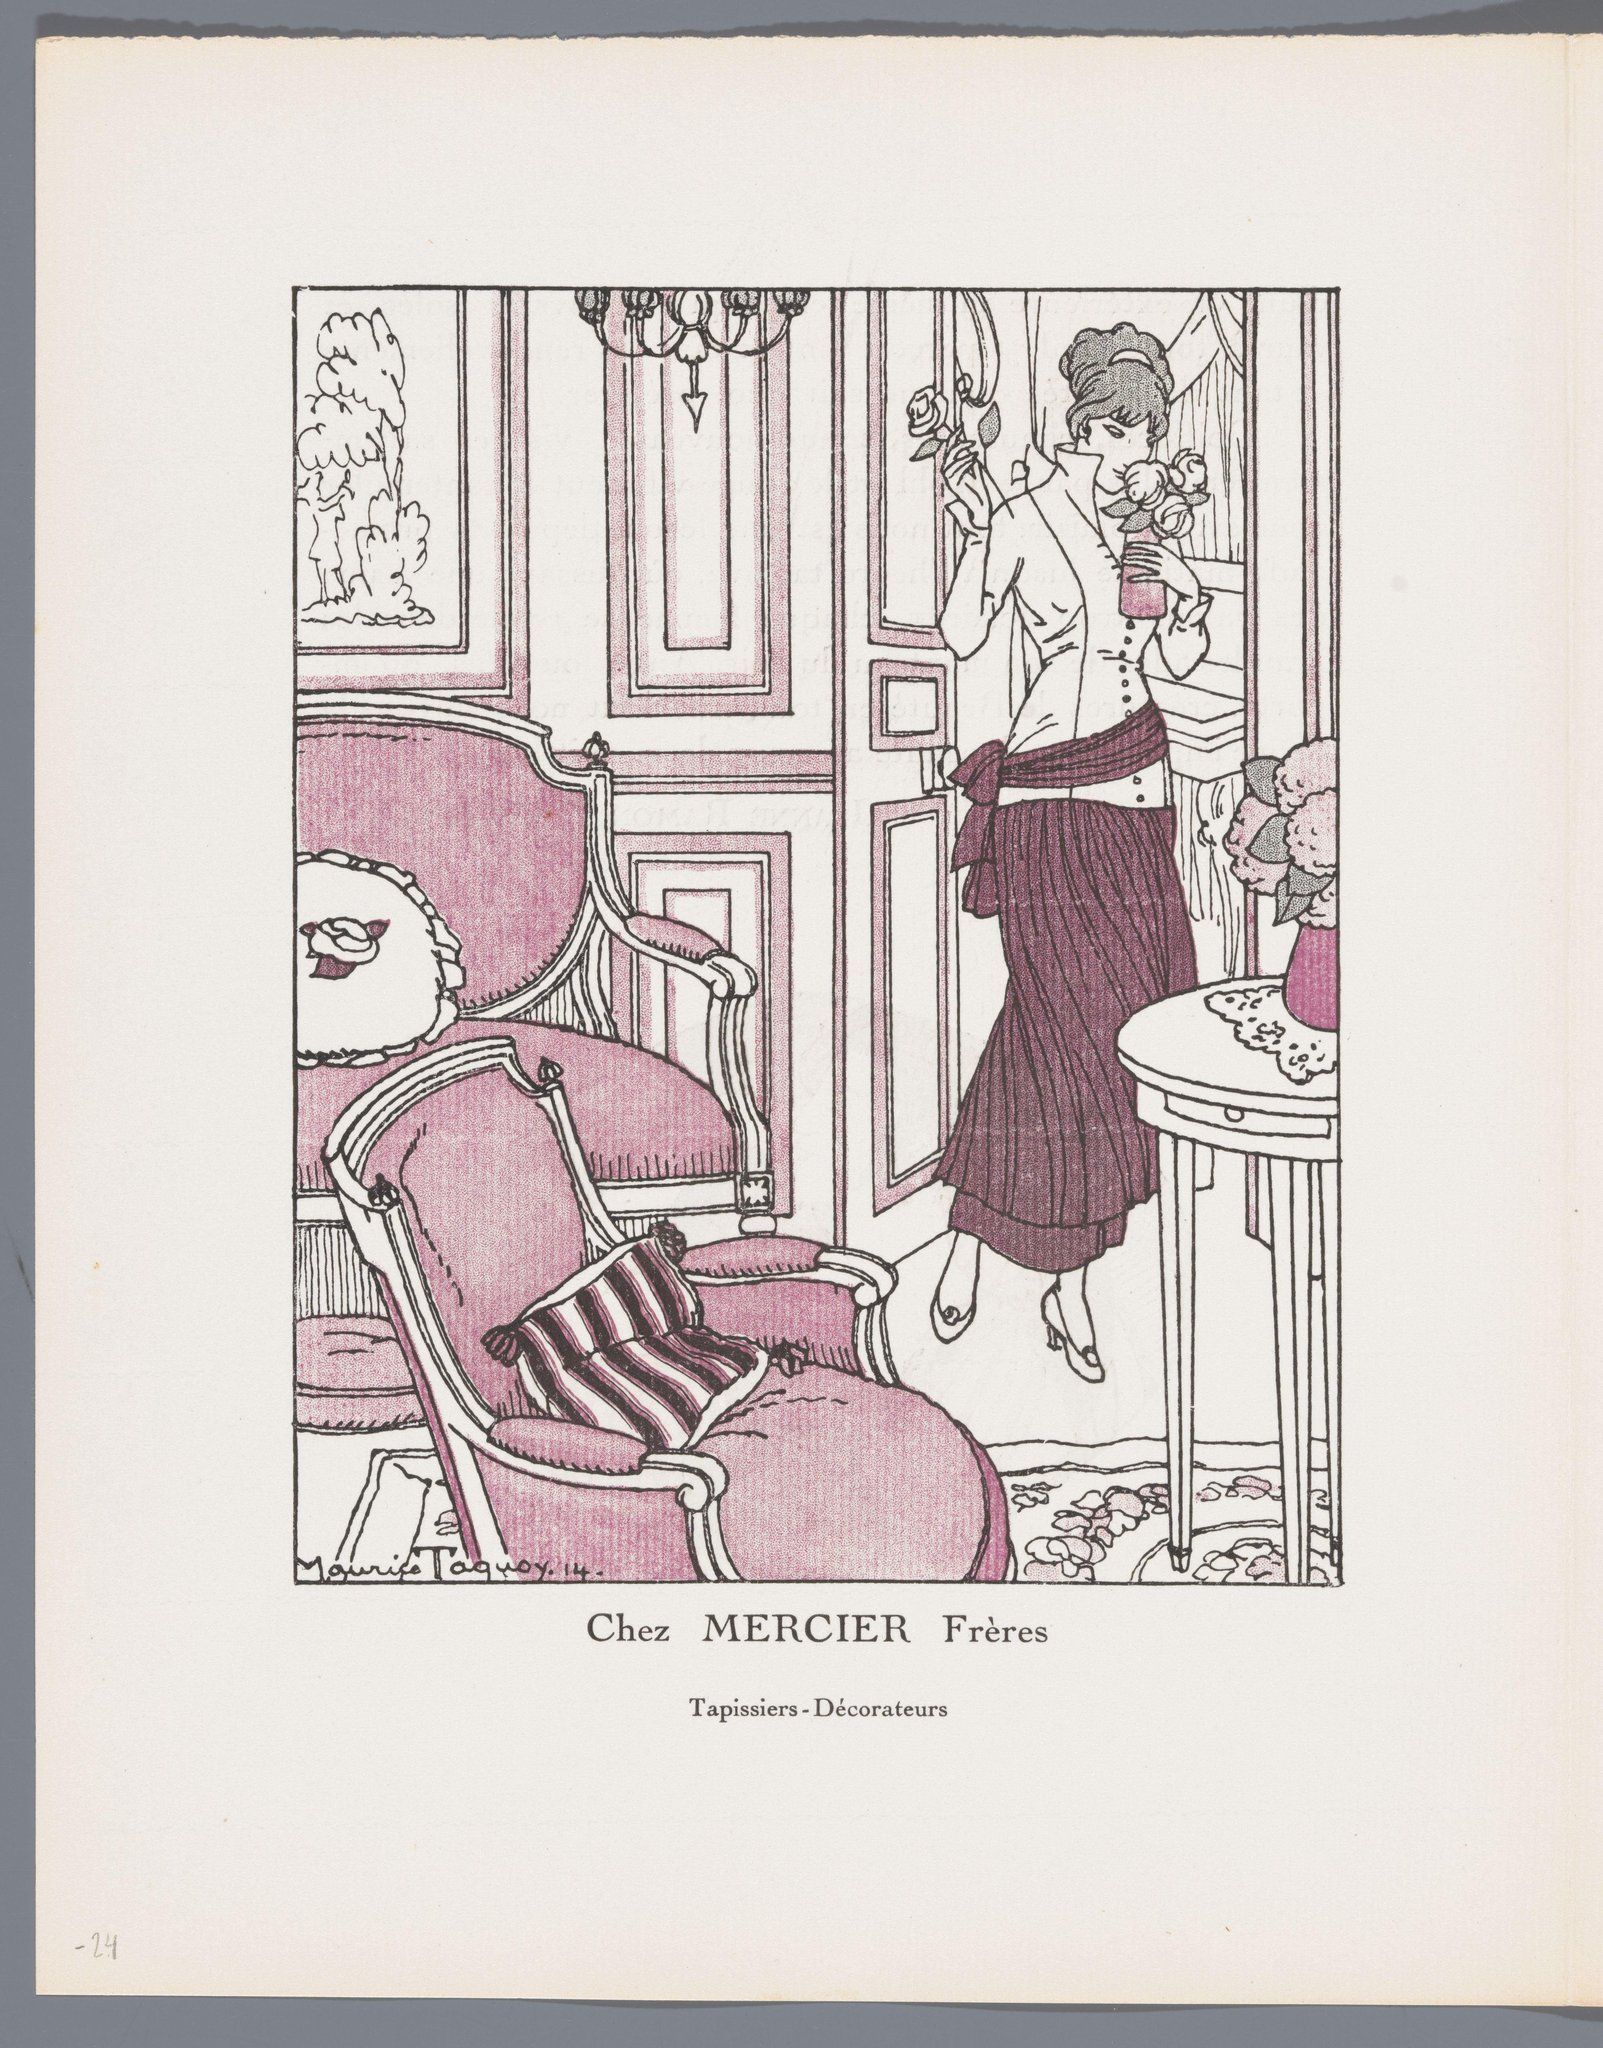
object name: fashion print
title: Gazette du Bon Ton, 1915 - No. 8-9: Advertentie 'Chez Mercier Frères", Tapissiers-Décorateurs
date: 1914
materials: paper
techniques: woodcut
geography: london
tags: fashion plates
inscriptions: date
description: Advertentie 'Chez Mercier Frères", Tapissiers-Décorateurs. Interieur waarin een jonge vrouw met vaas in de handen. Gazette du Bon Ton 1915, No. 8-9.